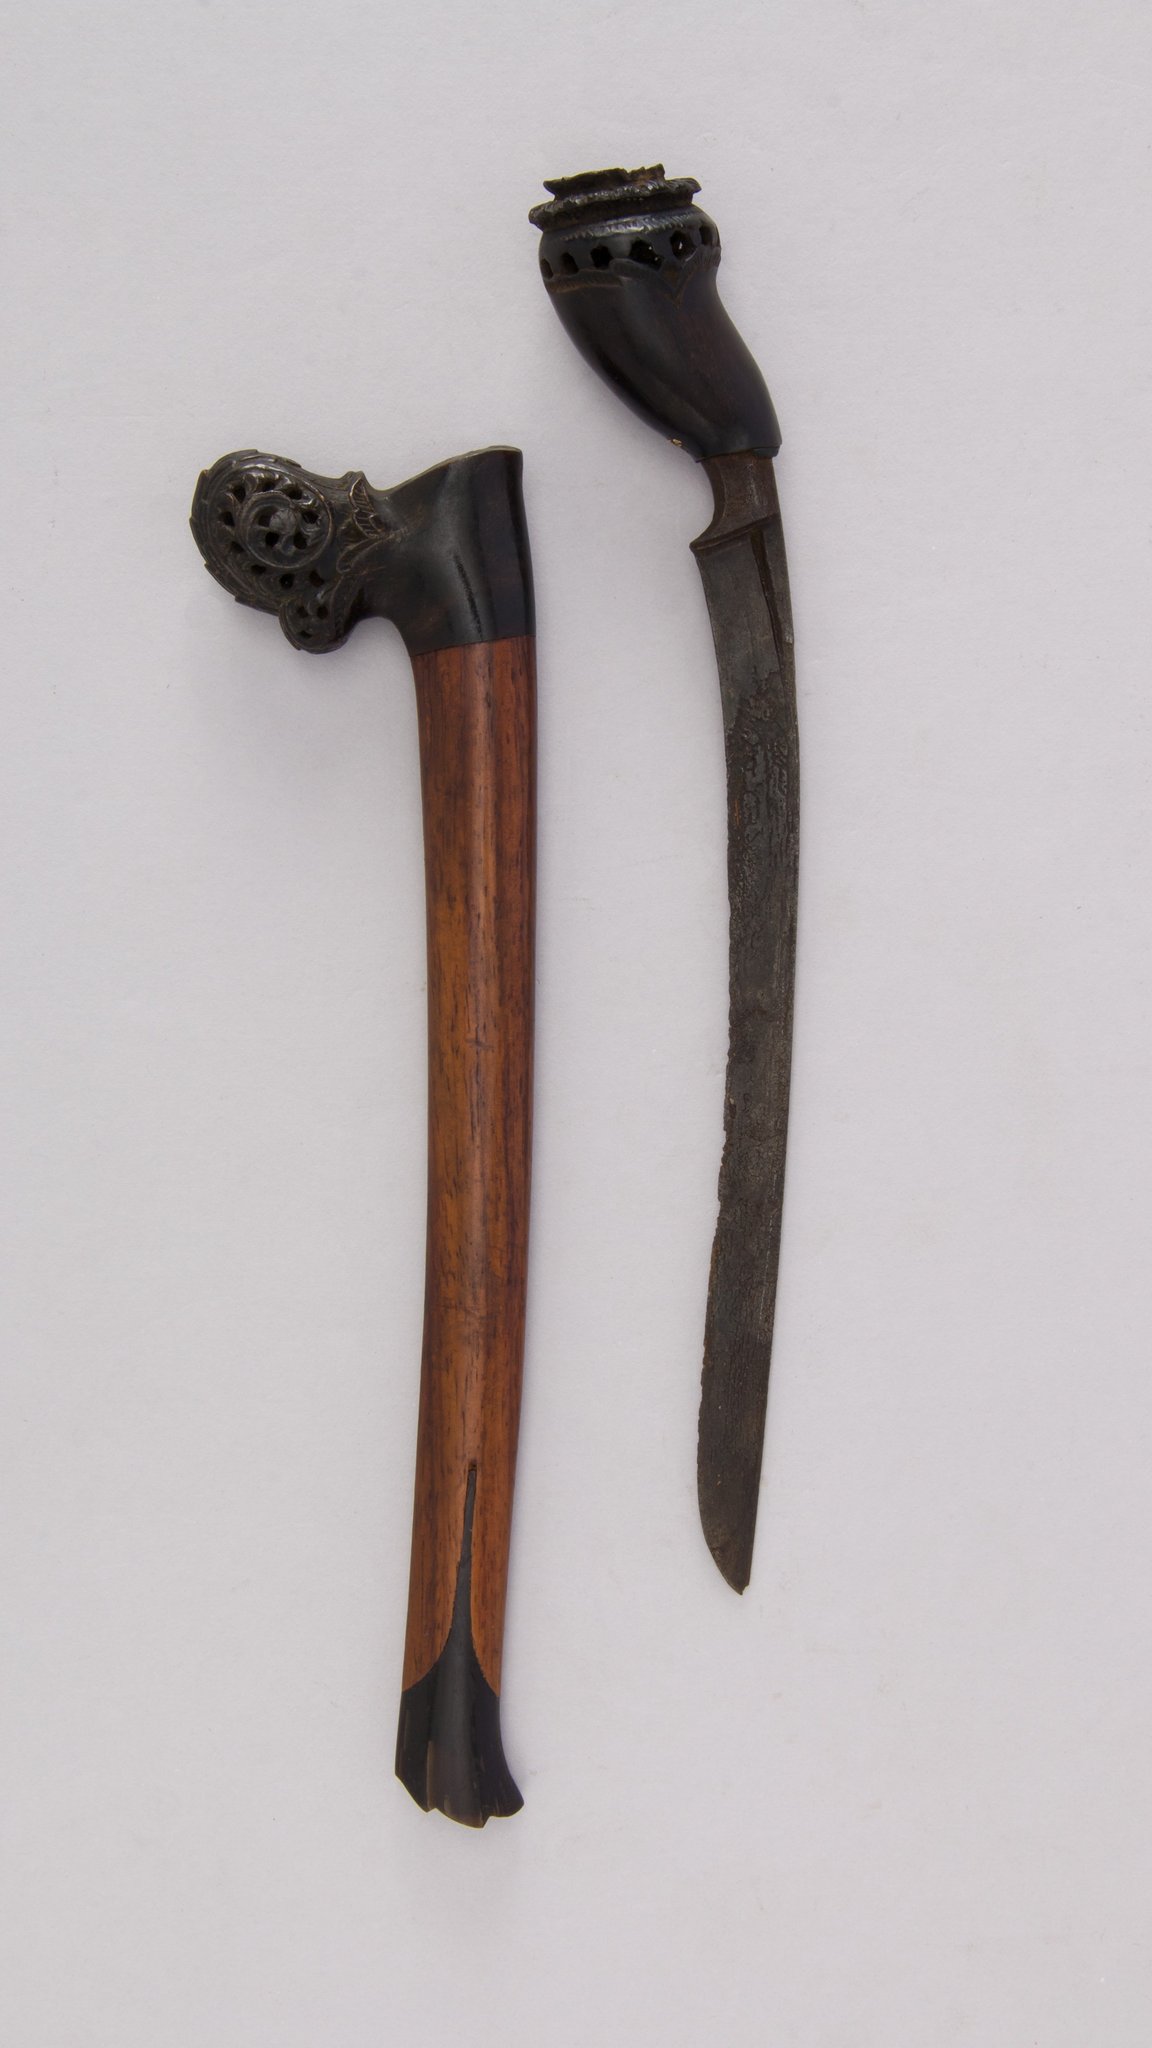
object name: knife bade bade with sheath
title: Knife (Bade-bade) with Sheath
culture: malayan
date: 1701-1900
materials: horn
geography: malaysia